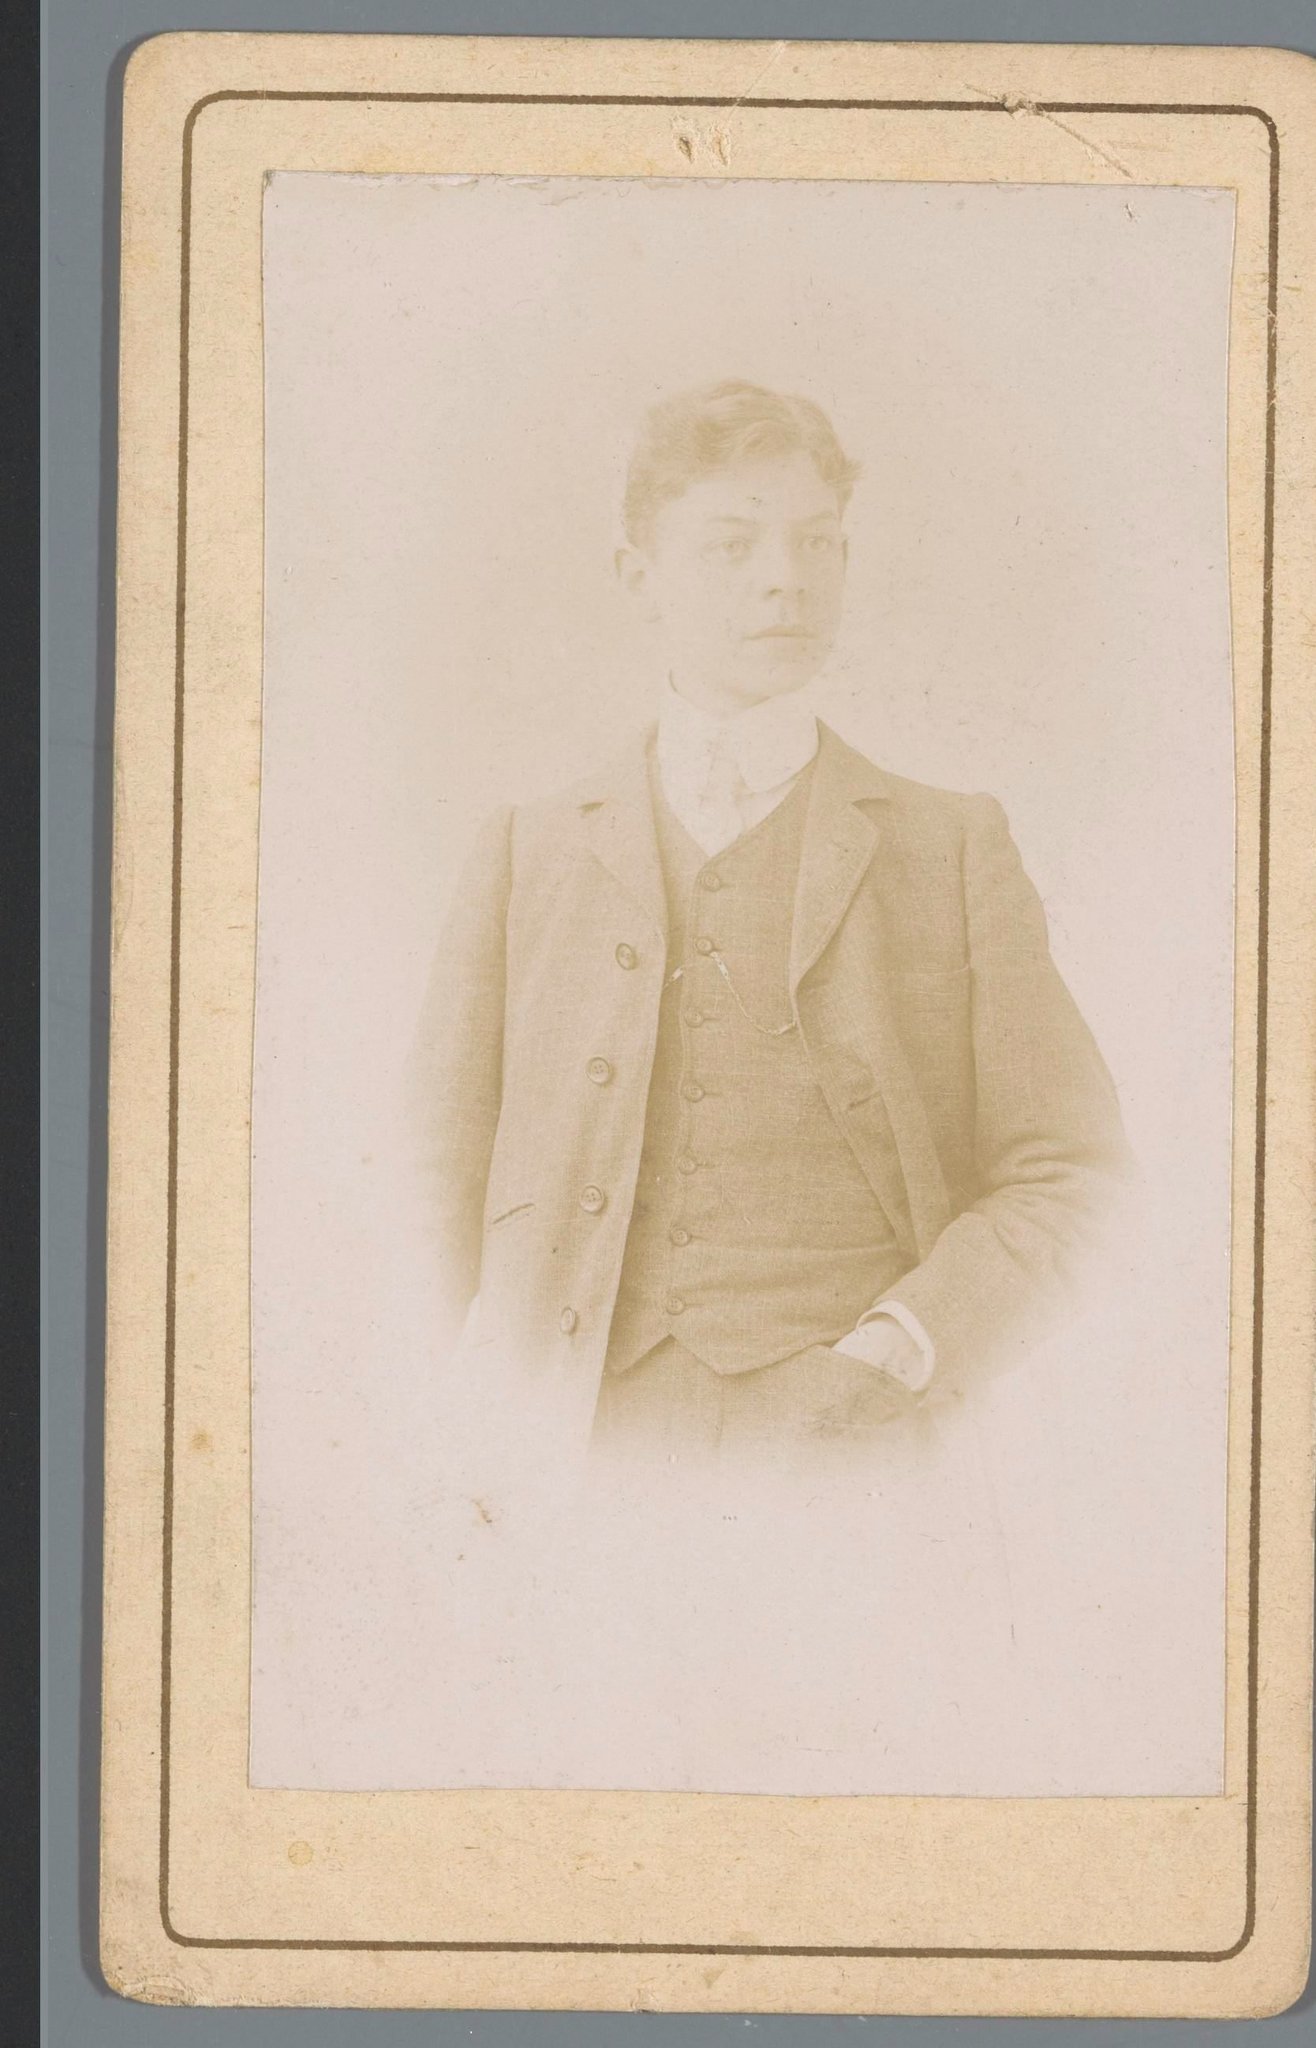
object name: photograph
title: Portret van een onbekende jongeman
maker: Anonymous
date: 1890-1920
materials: paper, cardboard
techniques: gelatin silver print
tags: youth, adolescent, anonymous historical person portrayed